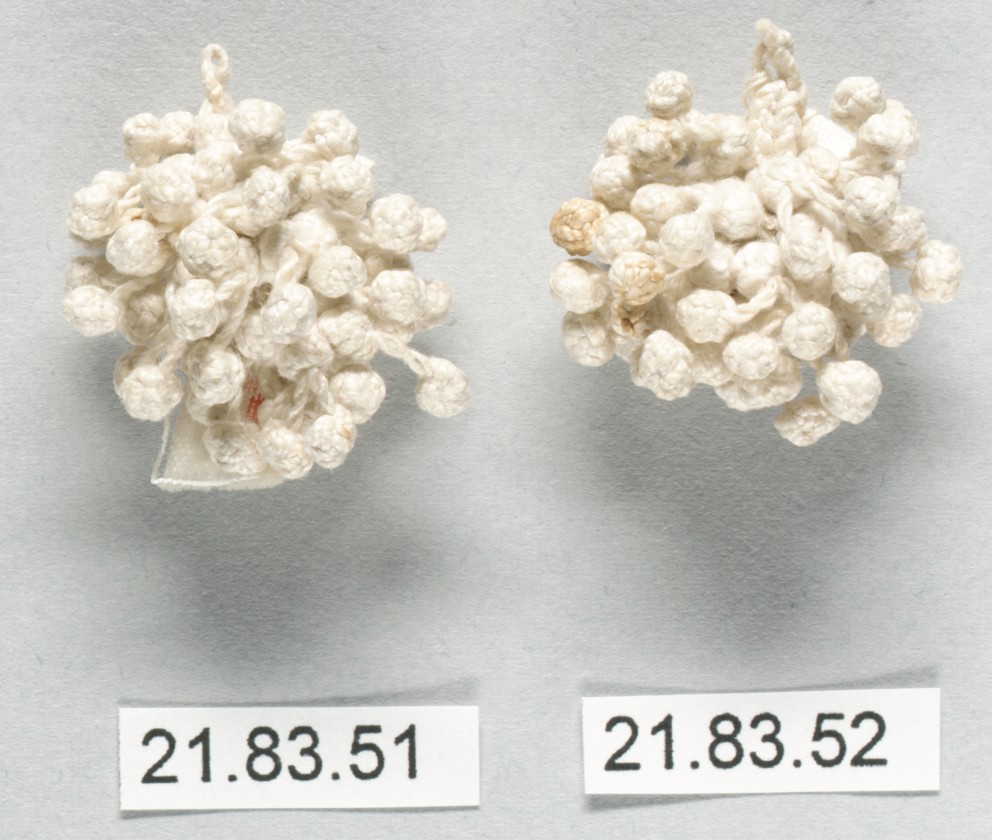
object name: tassel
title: Group of tassels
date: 1601-1700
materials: linen